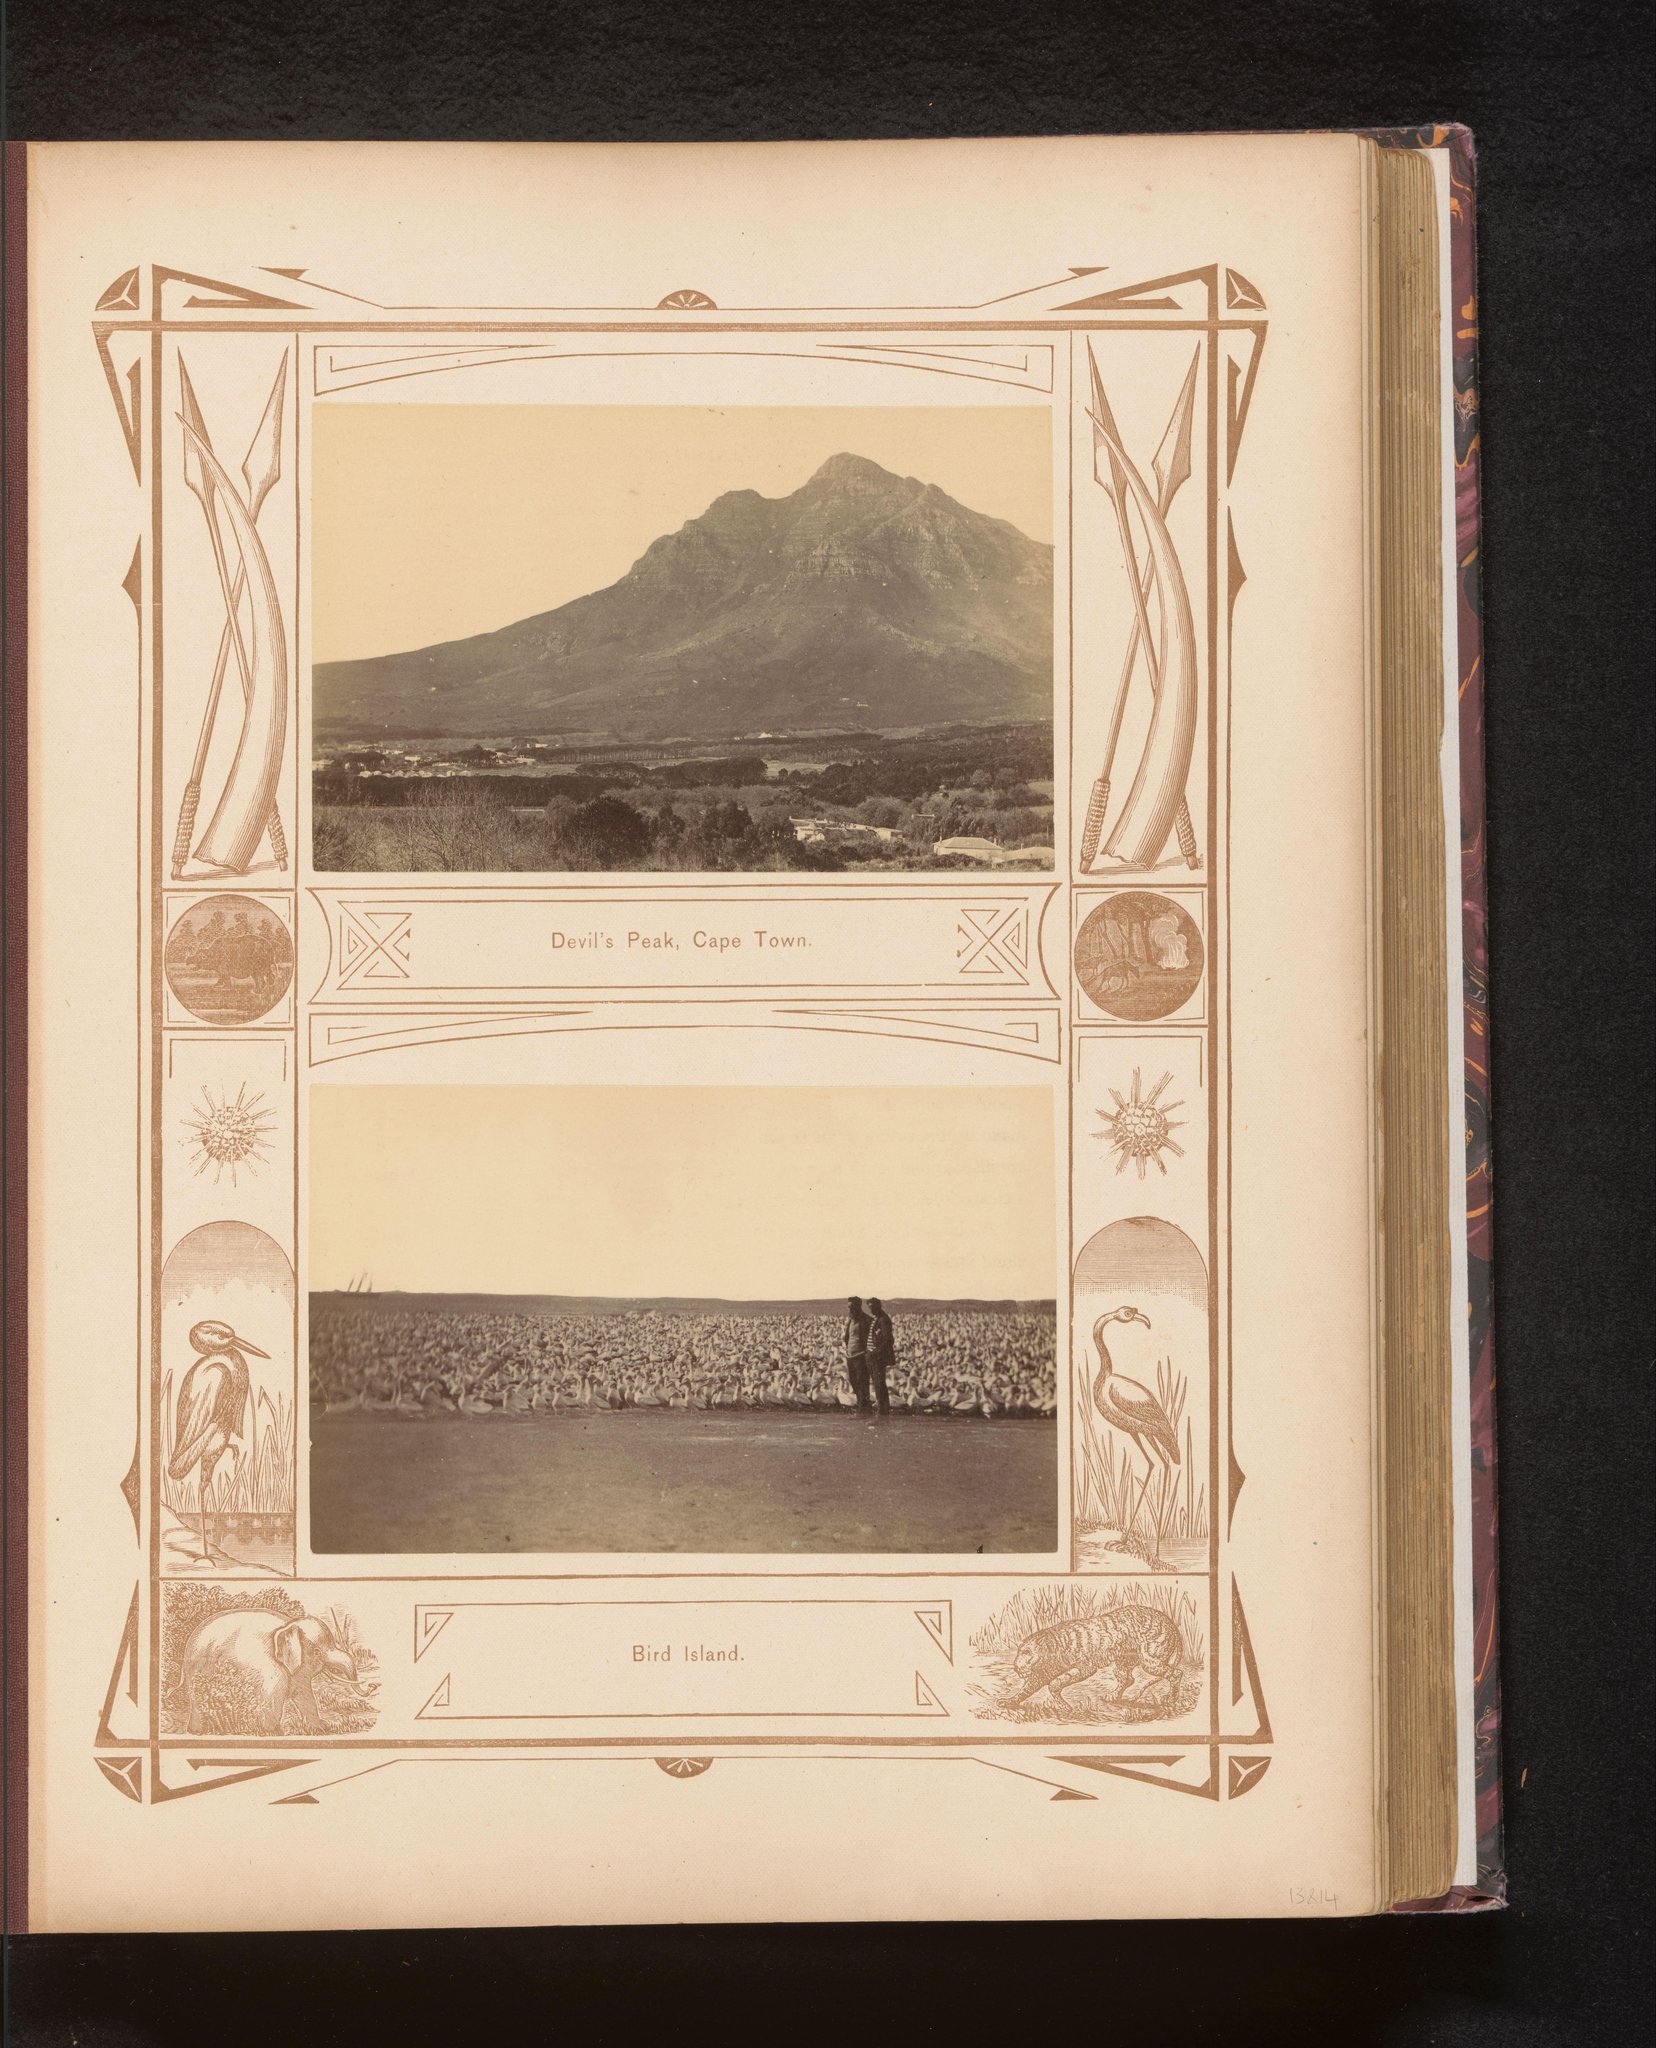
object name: photograph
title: Bird Island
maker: Anonymous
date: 1877-1882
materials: photographic support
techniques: albumen print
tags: birds, historical persons